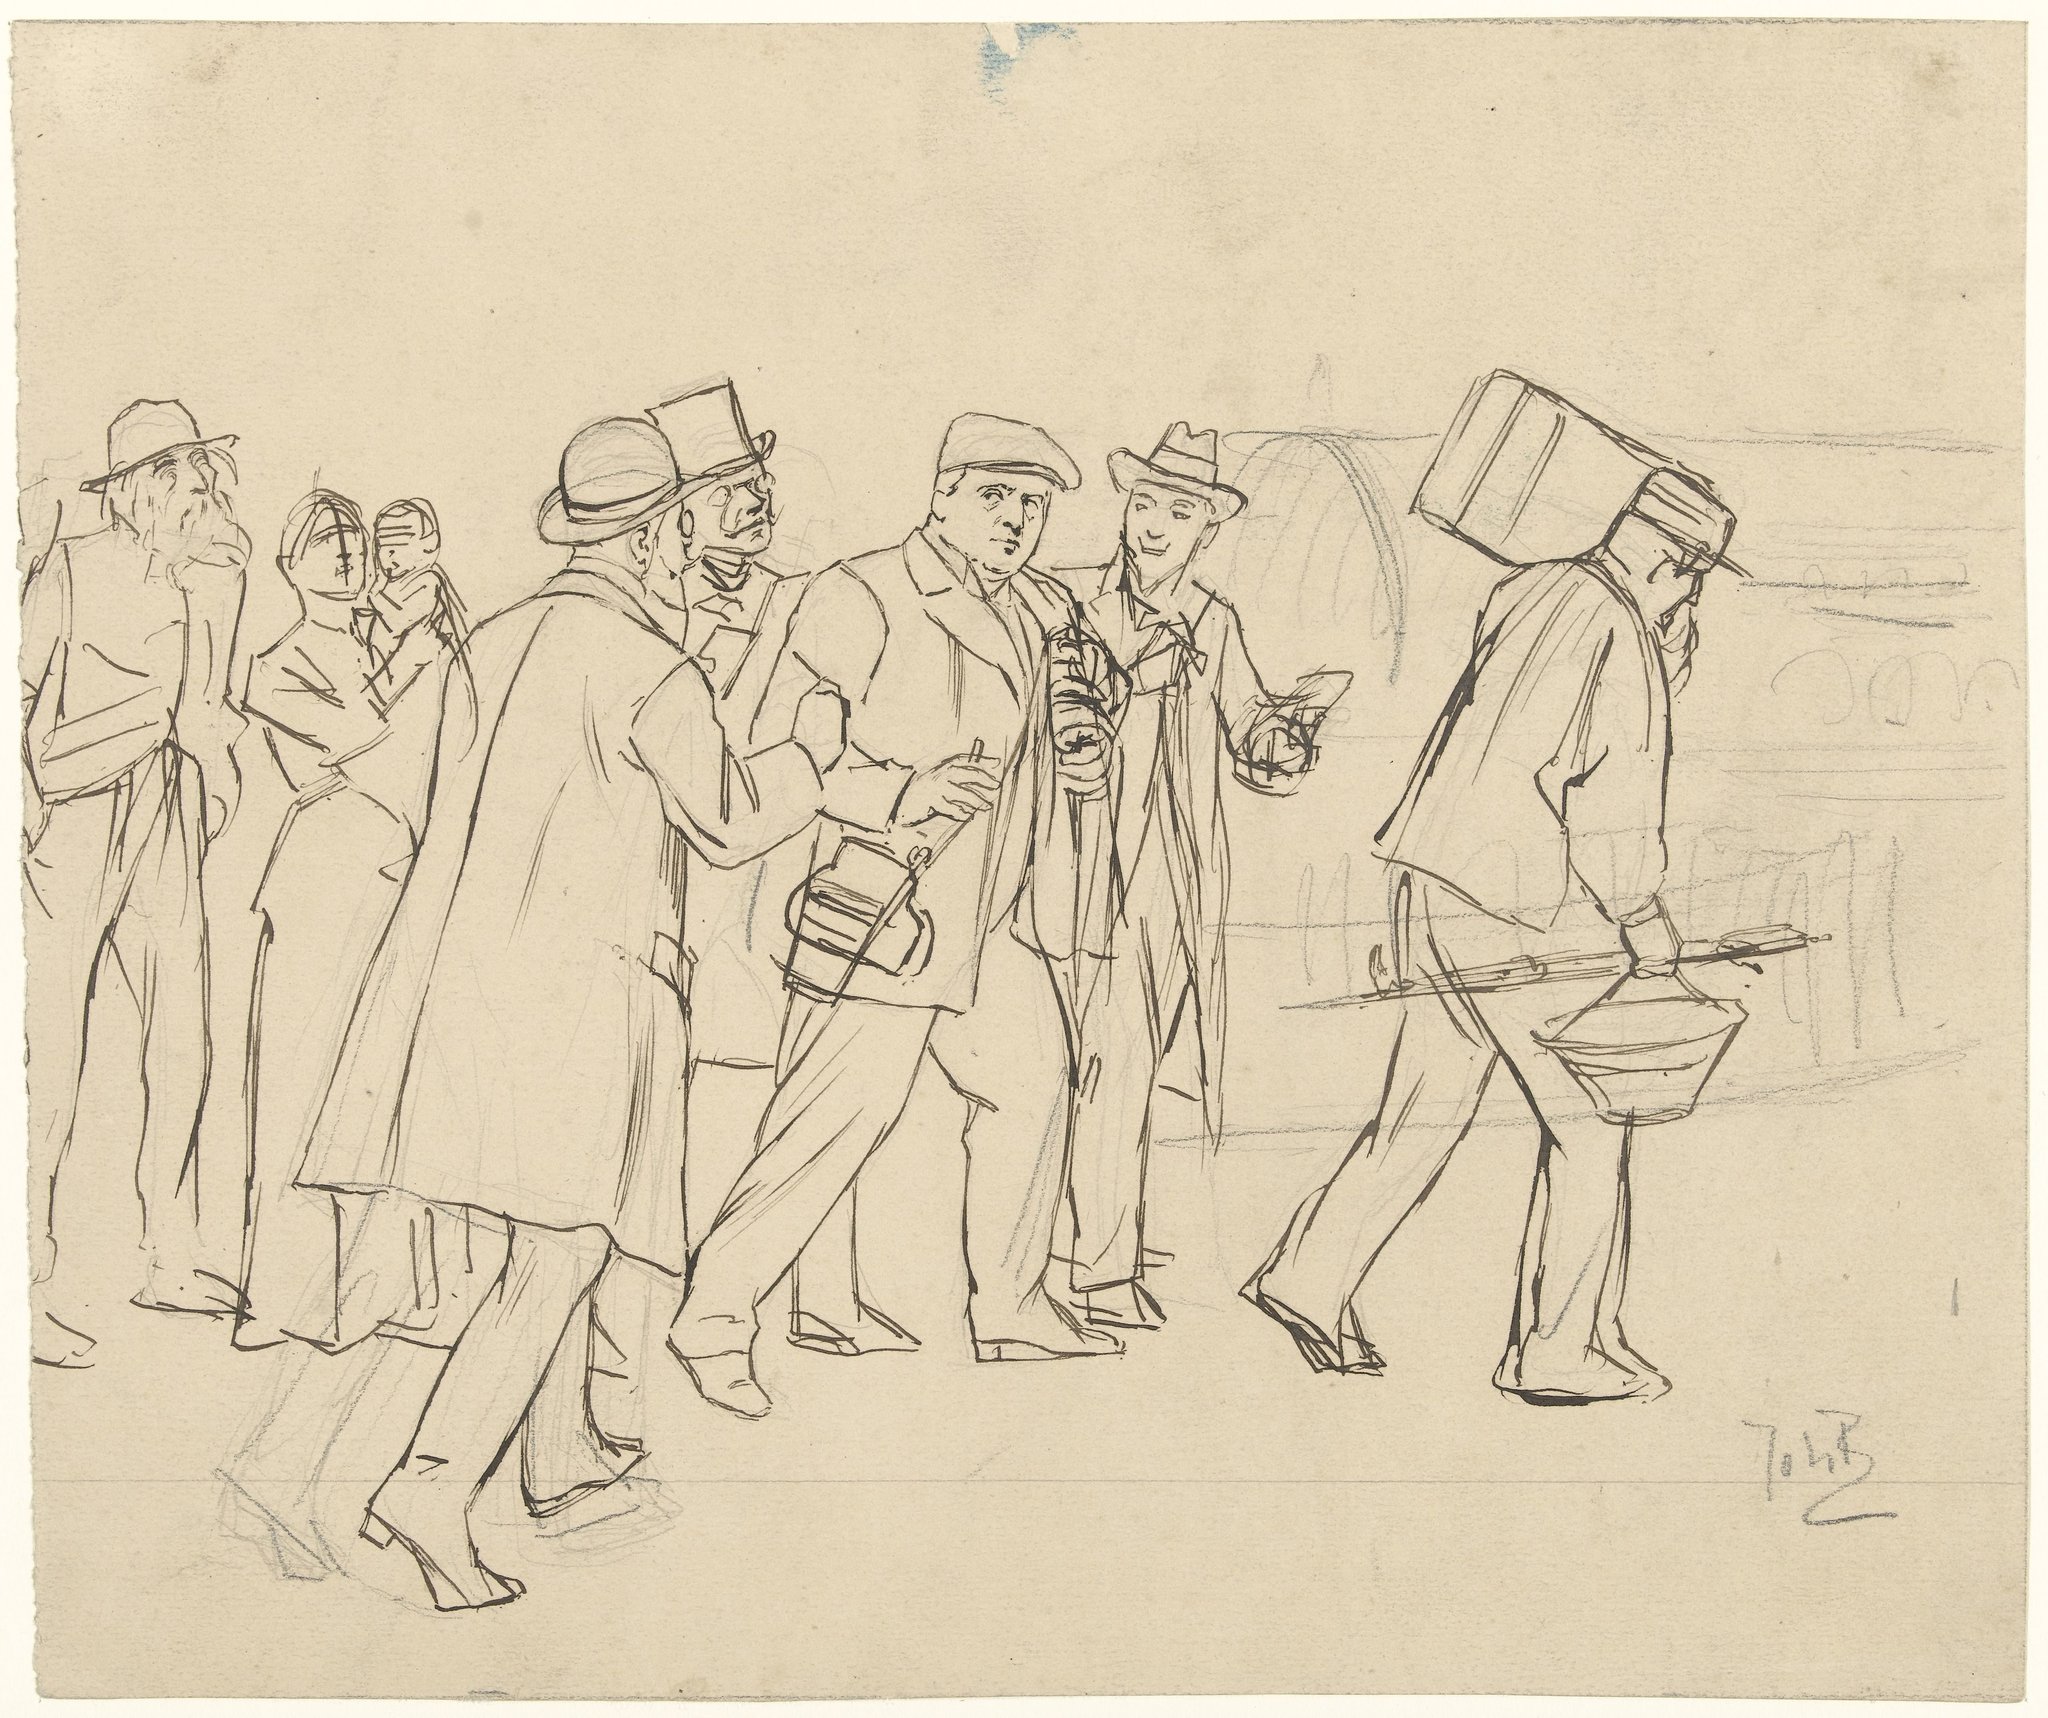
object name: drawing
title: Man op straat aangesproken door een groep heren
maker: johan braakensiek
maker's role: draughtsman, print maker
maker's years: 1858-1940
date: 1868-1940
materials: ink, paper, pencil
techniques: pen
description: Man op straat aangesproken door een groep heren; op de verso een staande man met hoge hoed. Mogelijk een ontwerp voor een prent.